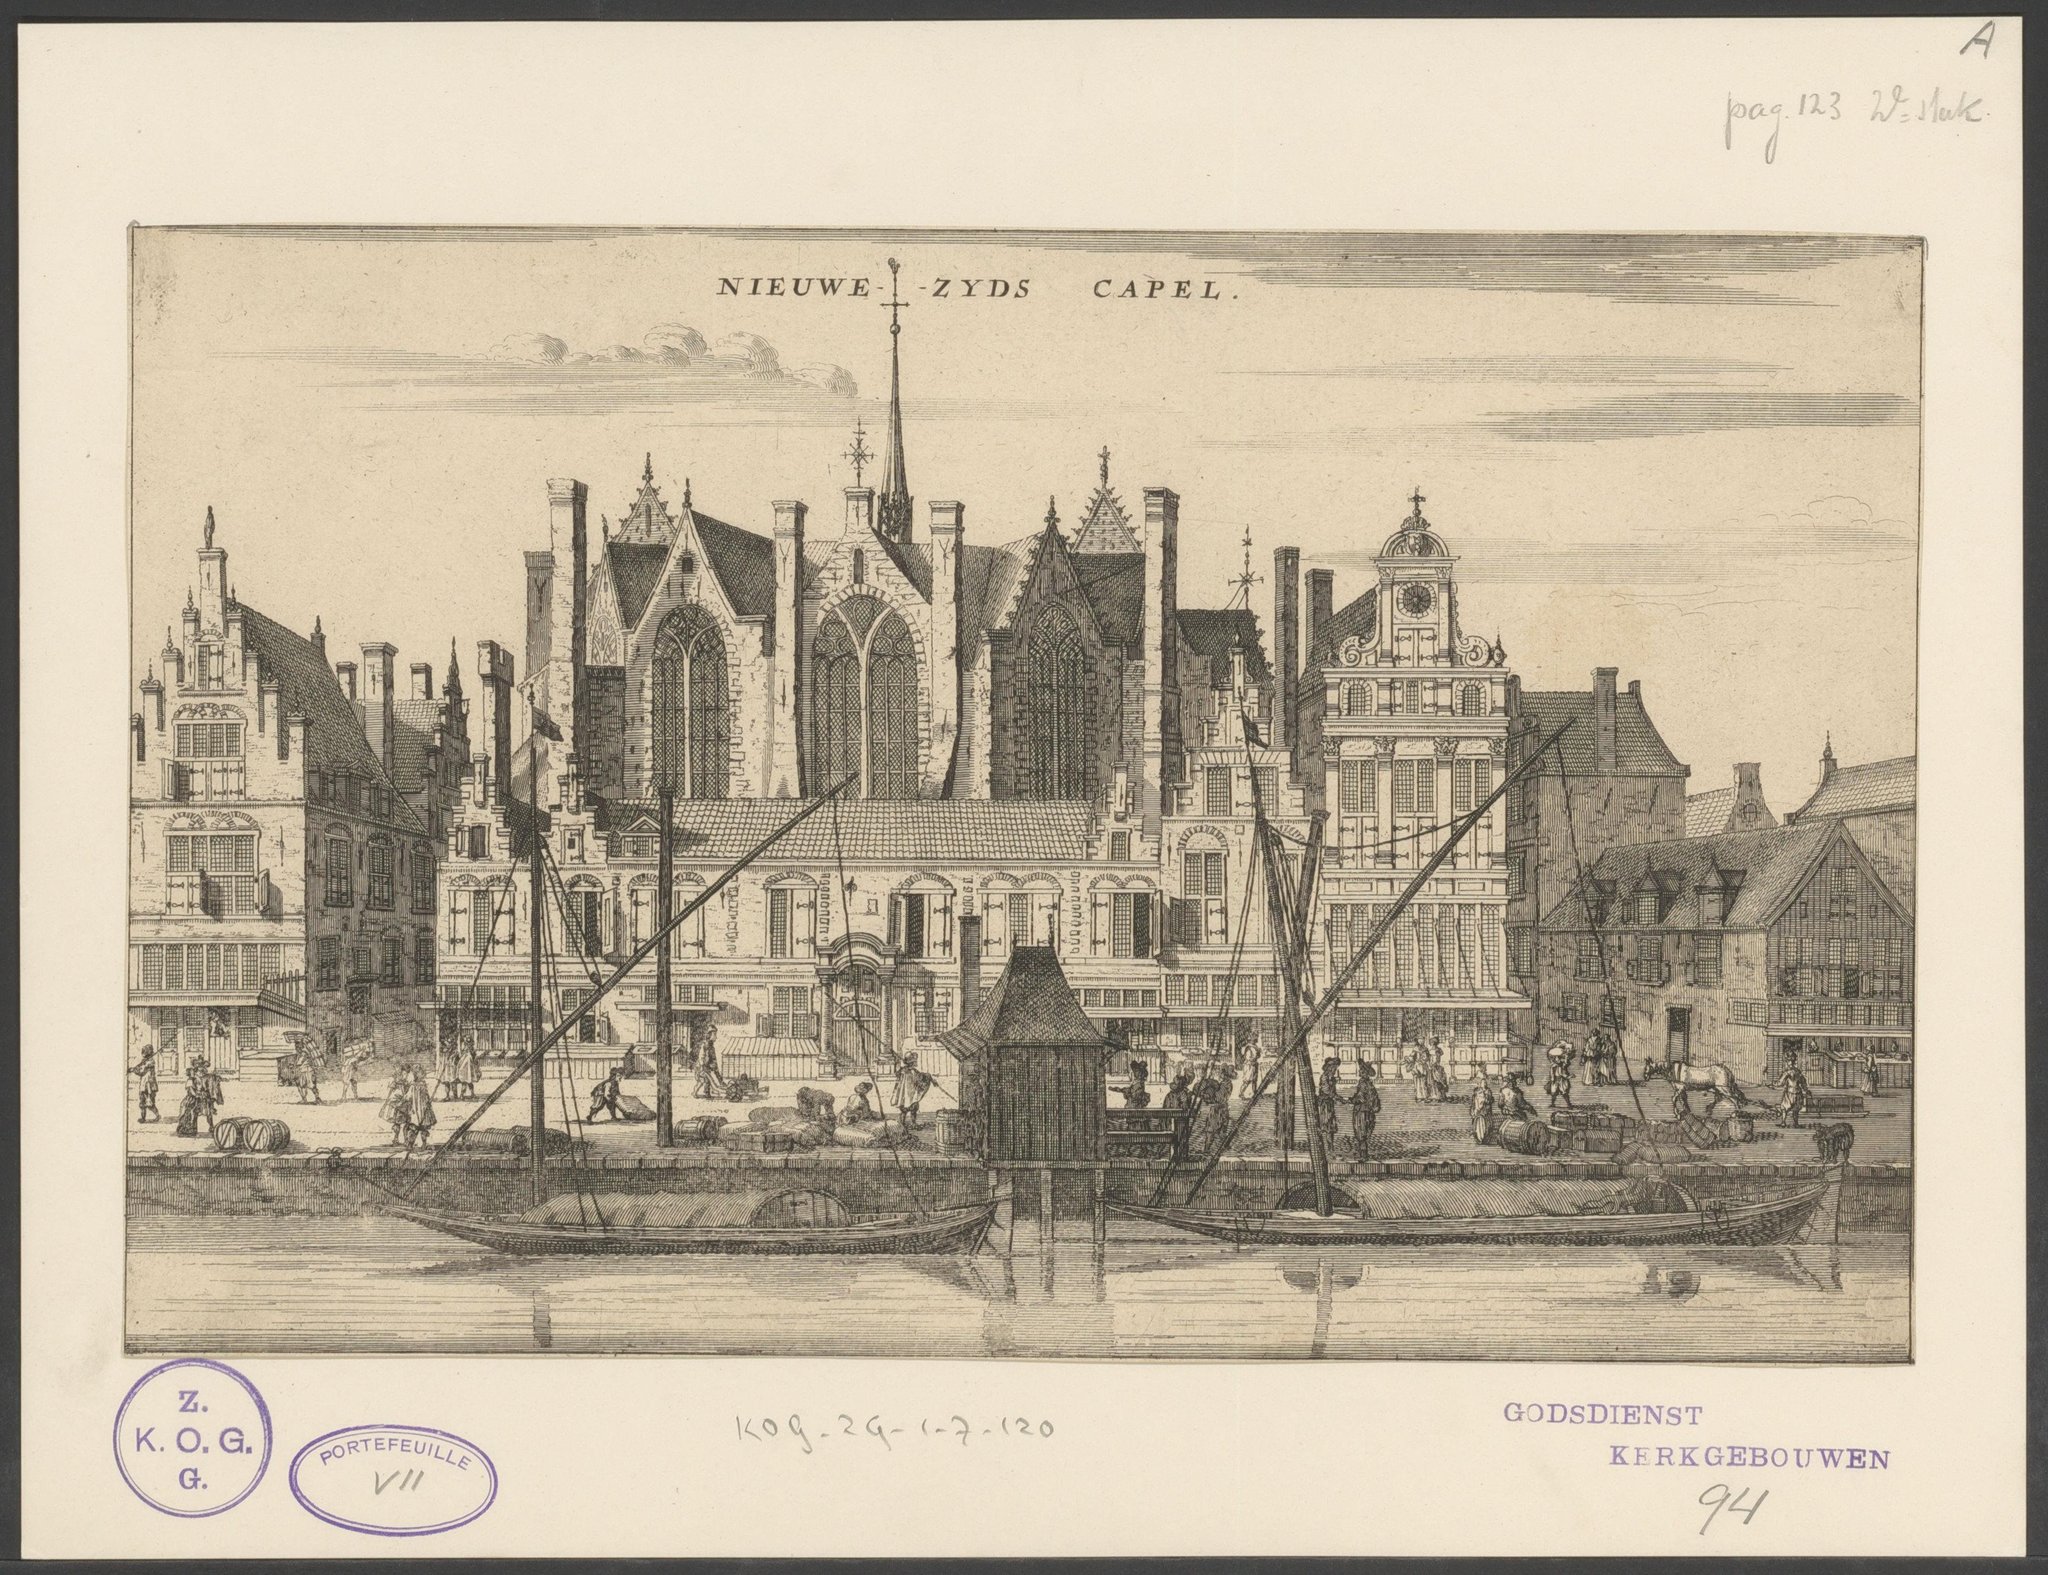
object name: print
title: Gezicht op de Nieuwezijds Kapel te Amsterdam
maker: jacob van meurs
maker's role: draughtsman, print maker, publisher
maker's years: 1619-1680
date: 1663-1664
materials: paper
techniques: etching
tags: sailing-ship, sailing-boat, canal, church (exterior), street (+ city(-scape) with figures, staffage)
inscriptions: collector's mark: Lugt 1641, stamp, stamp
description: Huidige staat van prent ook gebruikt in: Dapper, Olfert. Historische beschryving der stadt Amsterdam: waer in de voornaemste geschiedenissen (na een kort verhael van gansch Hollant en d'omleggende dorpen (…). Amsterdam: Jacob van Meurs, 1663.* En in: Zesen, Philipp von. Beschreibung der Stadt Amsterdam: darinnen von derselben ersten Ursprunge bis auf gegenwärtigen Zustand (…). Amsterdam: Joachim Nosche, 1664. * In sommige exemplaren van deze uitgave komt de huidige staat van de prent voor. In andere exemplaren is een latere staat ingebonden, waarop boven de Nederlandse een Franse titel is toegevoegd.